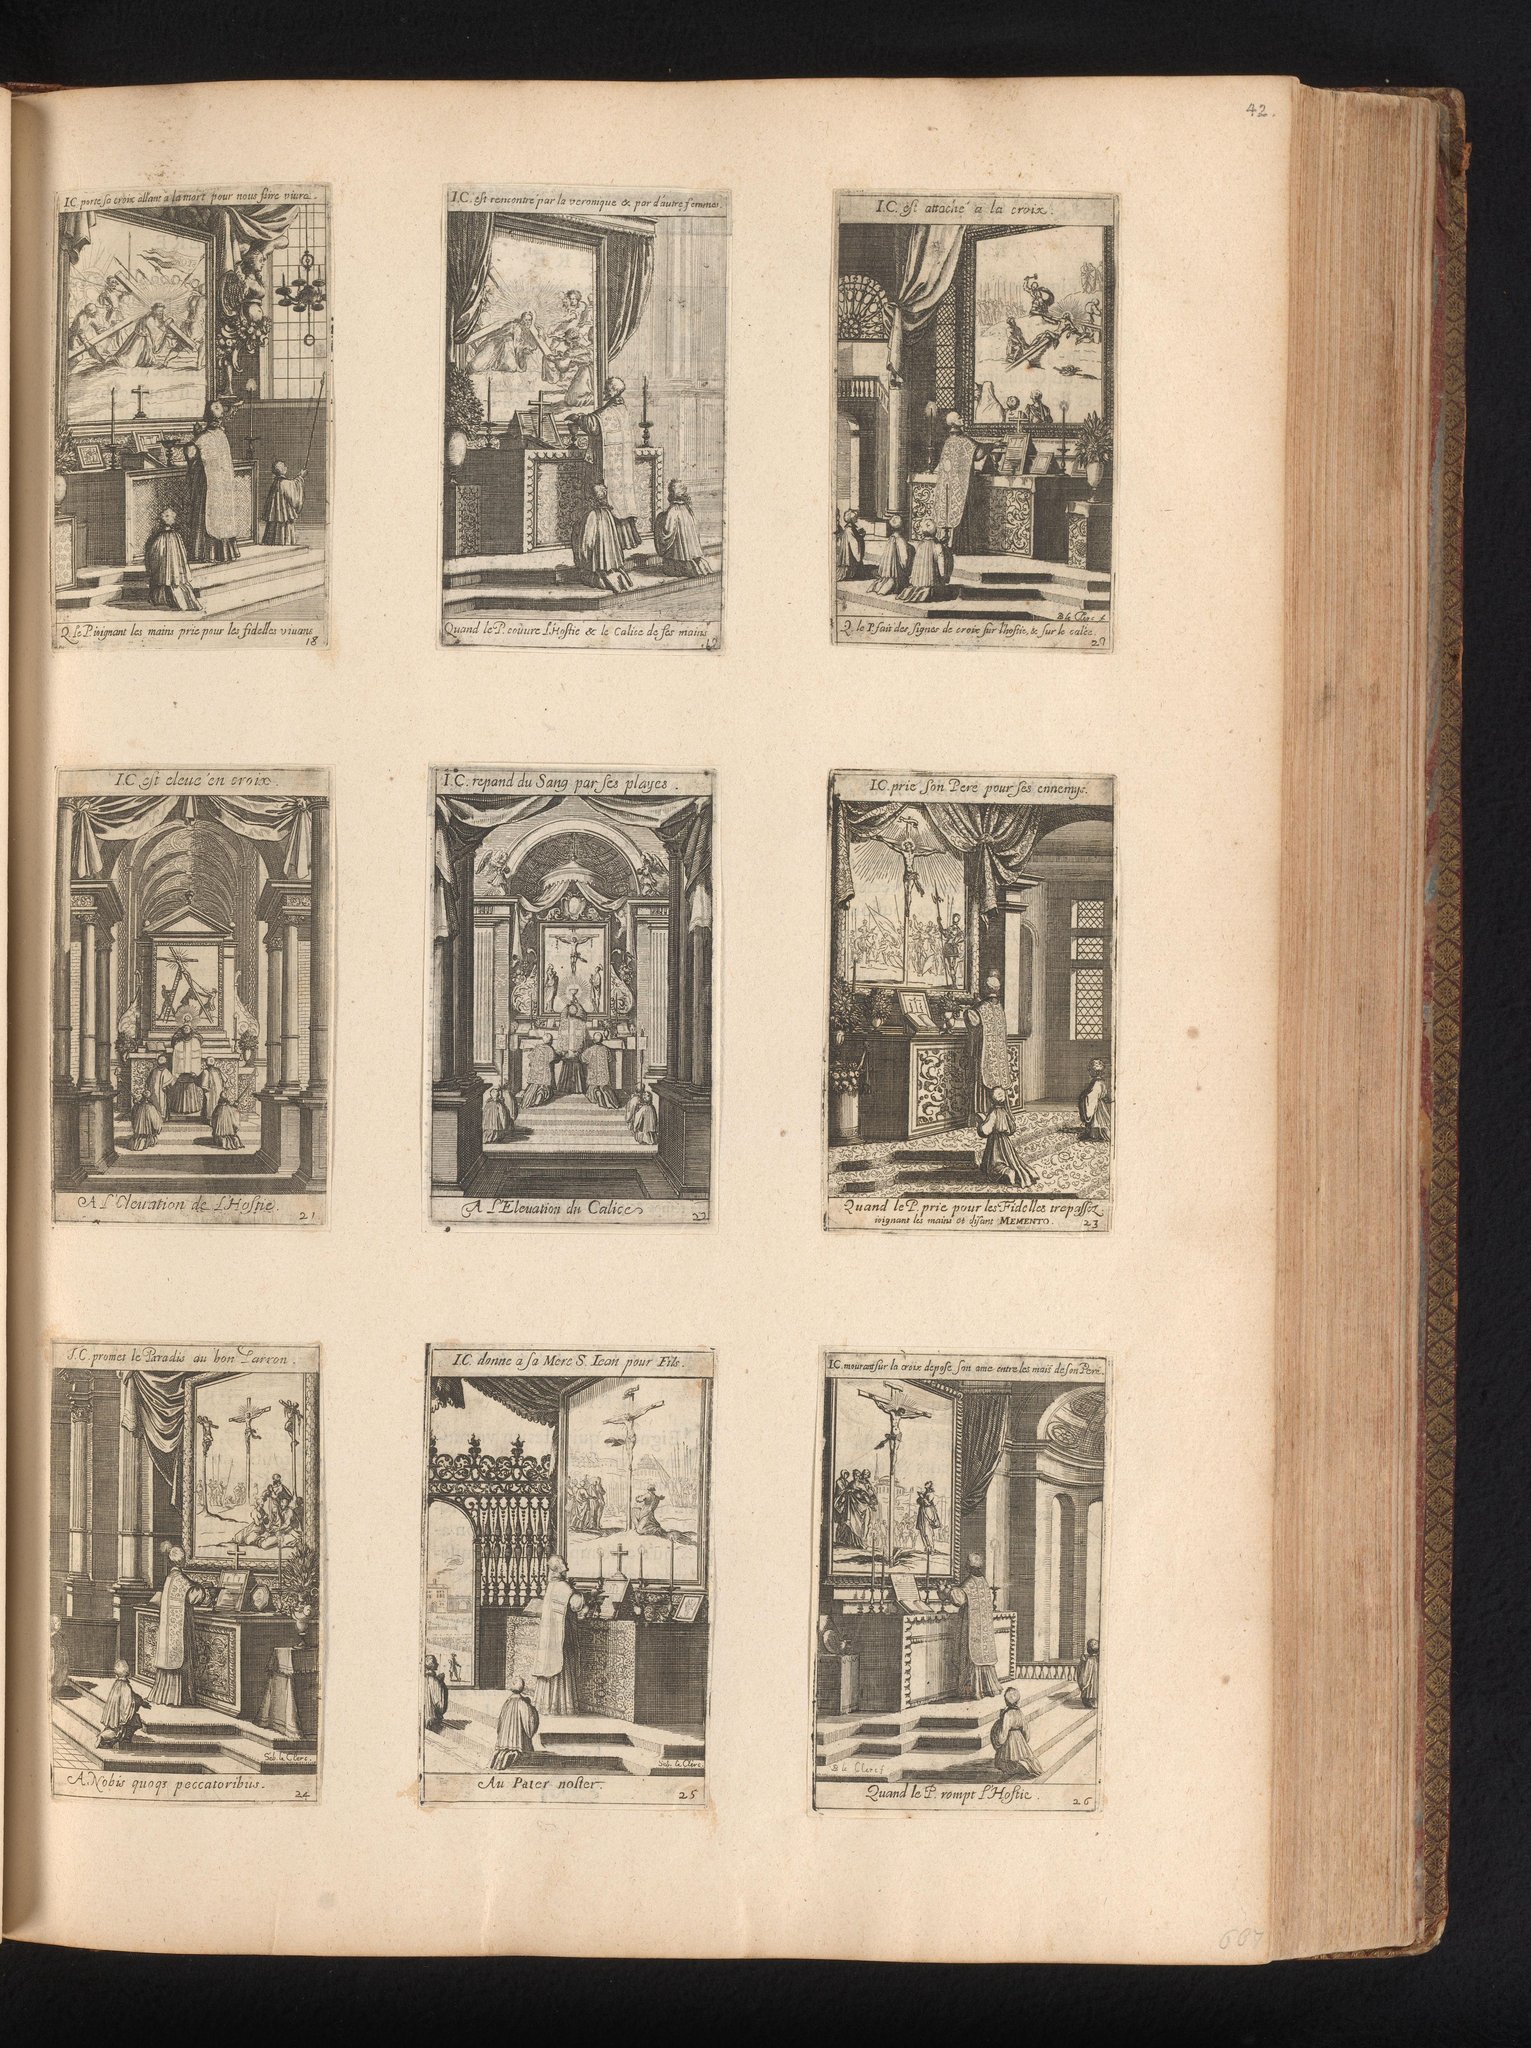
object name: print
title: Tableaux ou sont represetees la Passion de N.S. Jesus Christ (...)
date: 1661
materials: paper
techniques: etching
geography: metz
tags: priest (roman catholic), holy mass (divine service, especially of roman catholic church), altar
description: Prenten maken deel uit van een serie met 36 prenten met voorstellingen van gebruiken van priesters tijdens de mis. De serie wordt ook wel 'La Deuxième Messe' genoemd.